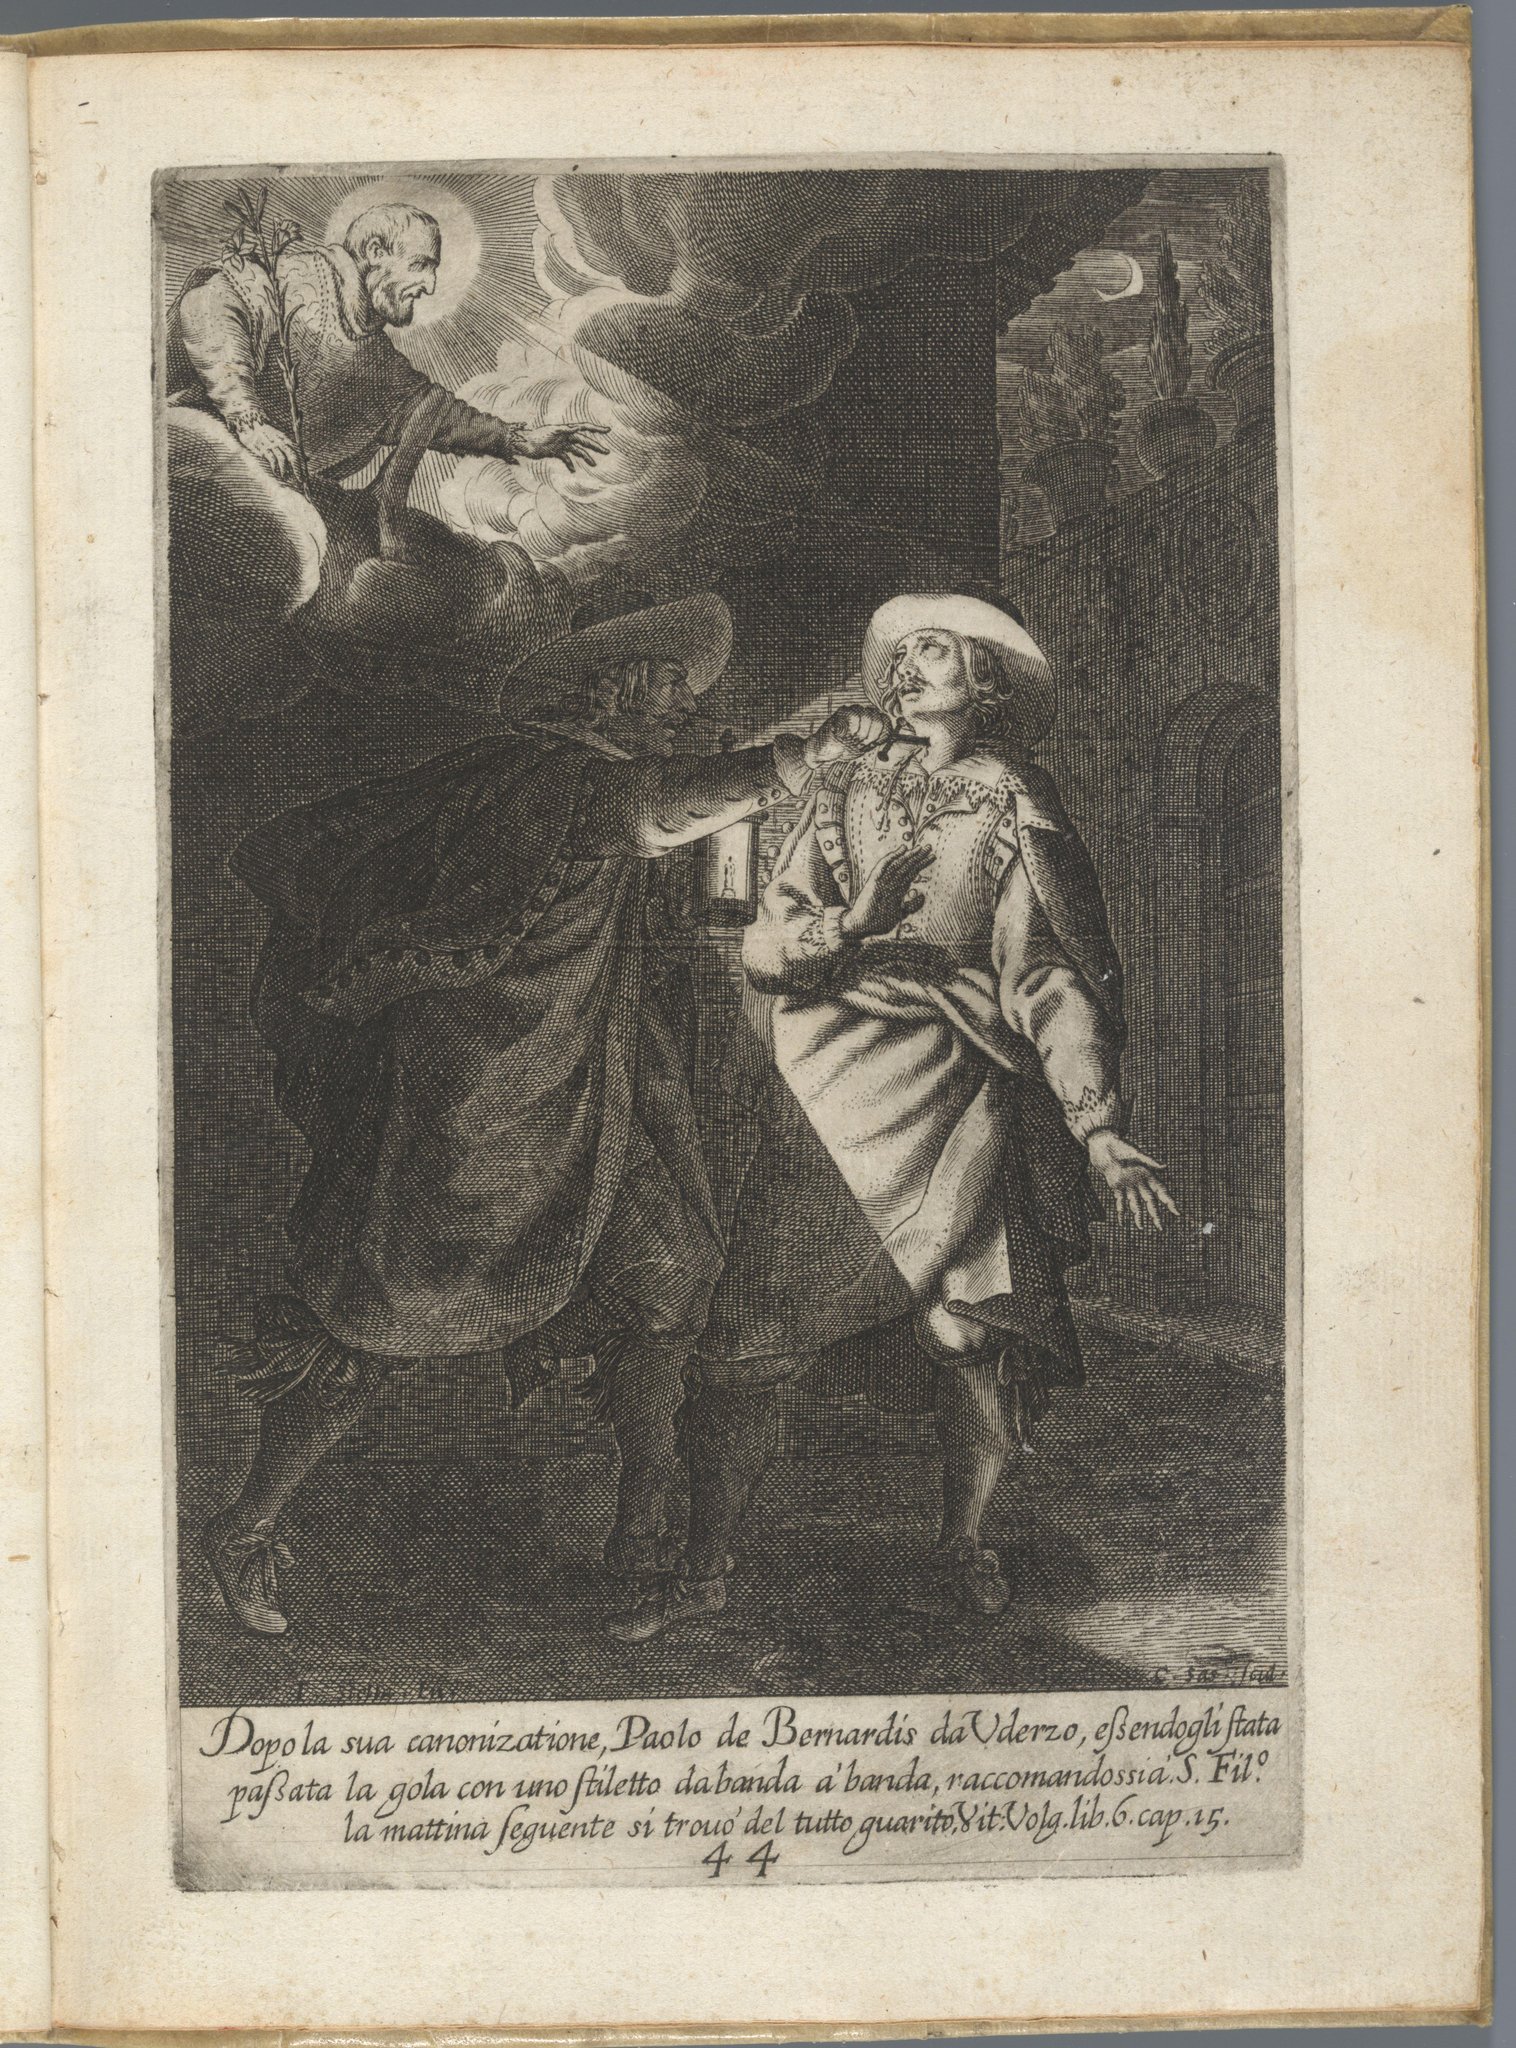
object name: print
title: Genezing van Paolo da Barnardis da Uderzo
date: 1630-1641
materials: paper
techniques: engraving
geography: rome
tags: clergyman, the founder of the congregation of the oratory (oratorians) philip neri; possible attributes: lily, rosary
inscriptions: collector's mark: Lugt 2760, collector's mark: Lugt 2228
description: Wonderlijke genezing van Paolo da Barnardis da Uderzo door Filippo Neri. Prent nr. 44 in een serie van 44 prenten met scènes uit het leven van de heilige Filippo Neri.